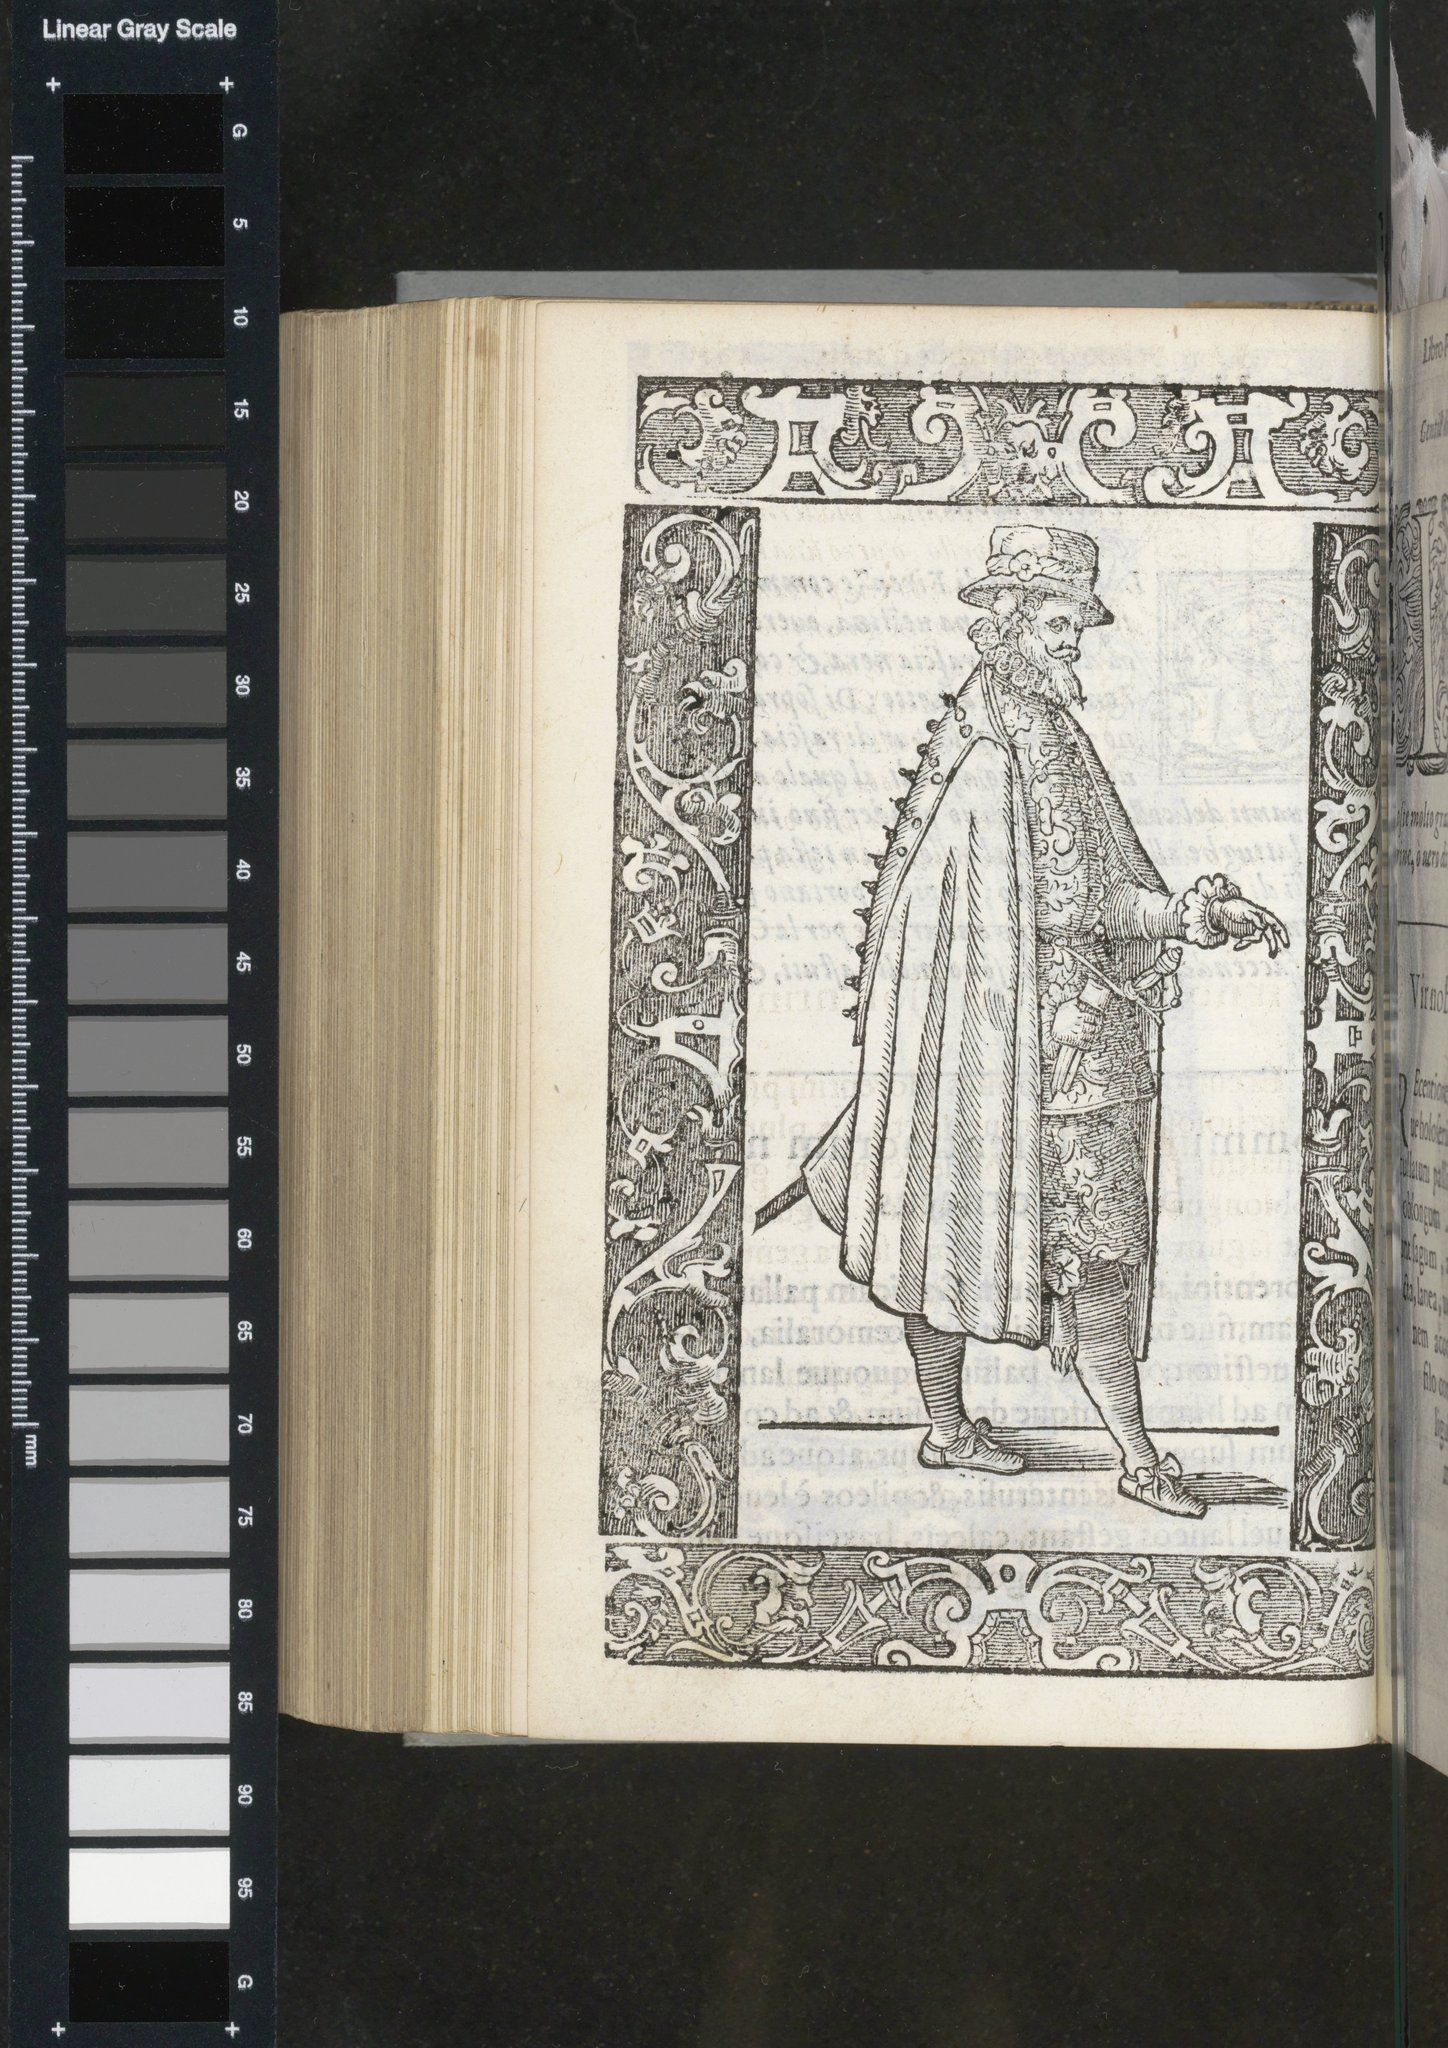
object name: costume print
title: Gentilhumo moderno Fiorentino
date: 1598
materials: paper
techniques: woodcut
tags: fashion plates